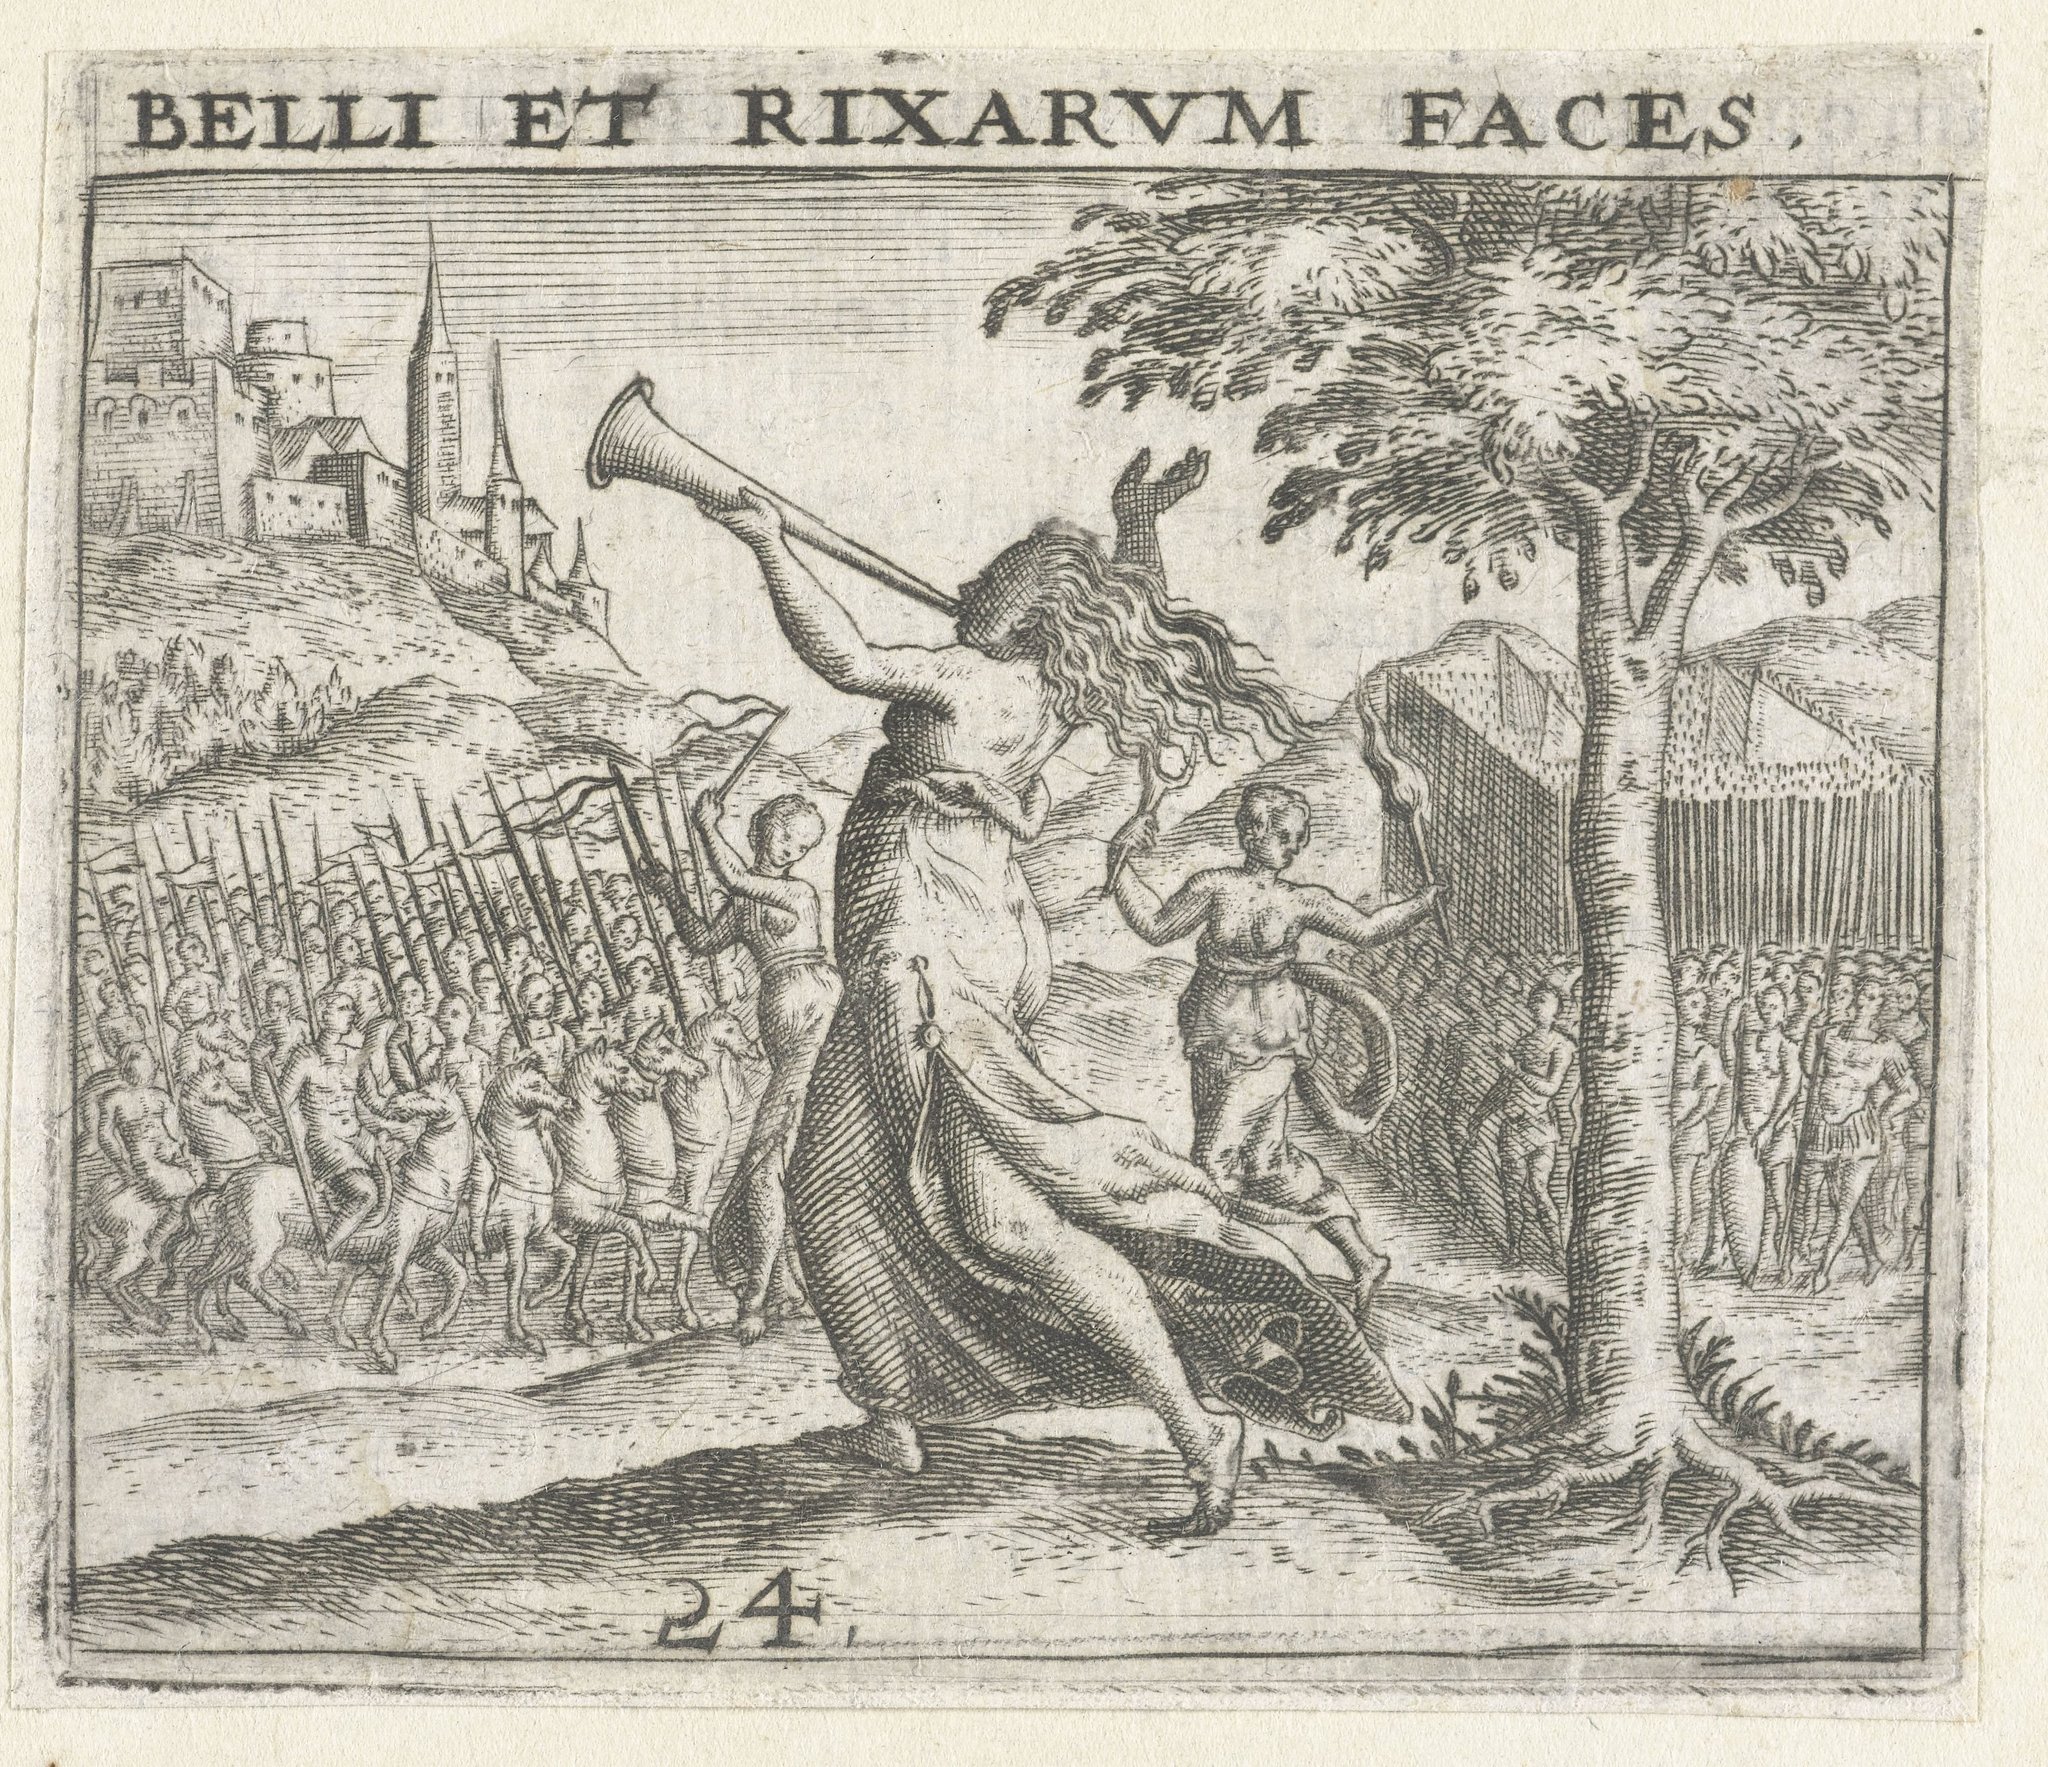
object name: print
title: Denis Lebey de Batilly, Emblemata, 1596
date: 1596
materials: paper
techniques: engraving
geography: frankfurt am main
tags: warfare; military affairs (+ before the battle)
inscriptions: collector's mark: Lugt 240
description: Op een slagveld staan voetsoldaten en soldaten te paard elkaar tegenover. Een vrouw op een bazuin geeft het startsein voor het gevecht. Twee andere vrouwen zwaaien met vlaggetjes en met een brandende toorts.